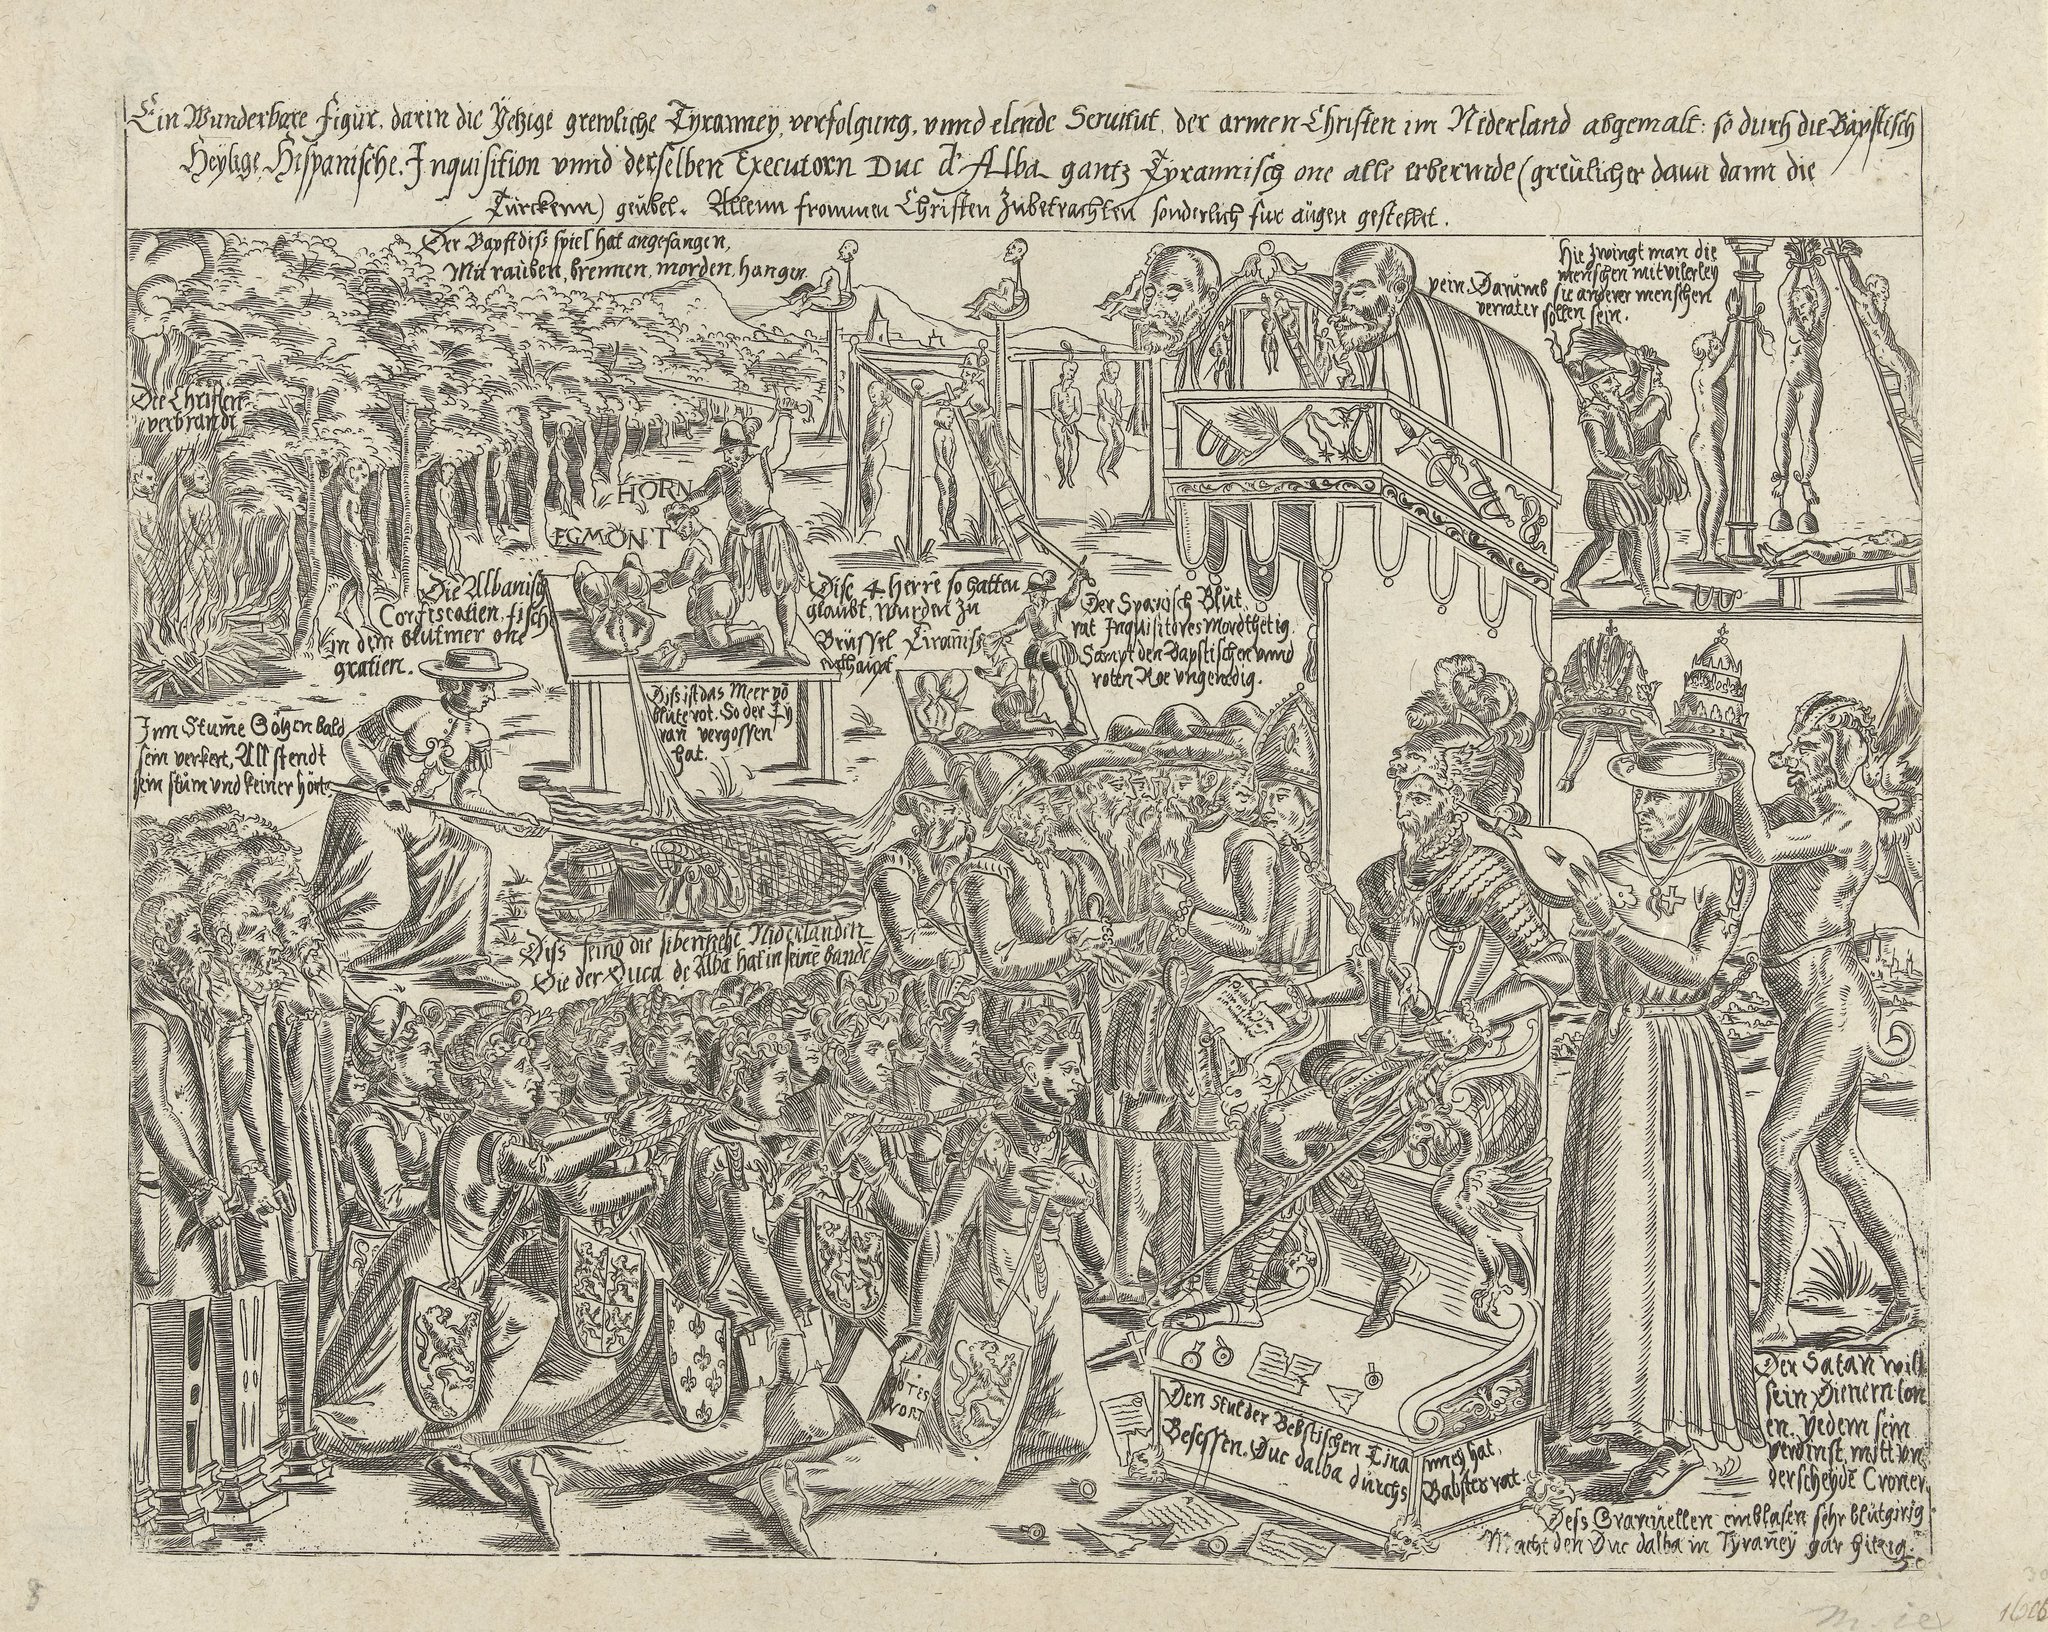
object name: print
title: De troon van de hertog van Alva, 1569 (kopie)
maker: Anonymous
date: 1569-1574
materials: paper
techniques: etching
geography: germany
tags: fernando álvarez de toledo (3rd duke of alba), antoine perrenot de granvelle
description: Allegorie op de tirannie van de hertog van Alva in de Nederlanden, 1569. Rechts Alva op zijn troon met Granvelle (met blaasbalg) en de duivel, links van zijn troon staan leden van de Bloedraad. Voor Alva knielen geketend de 17 personificaties van de provincies van de Nederlanden, rechts de verstomde leden van de Staten-Generaal. Hierboven vist een kardinaal naar rijkdommen in een bloedvijver, daarachter de onthoofding van Egmond en Horne en anderen te Brussel in 1568. Op de achtergrond scènes van martelingen en executies. In de voorstelling opschriften in het Duits. Met bovenschrift van 3 regels in het Duits.